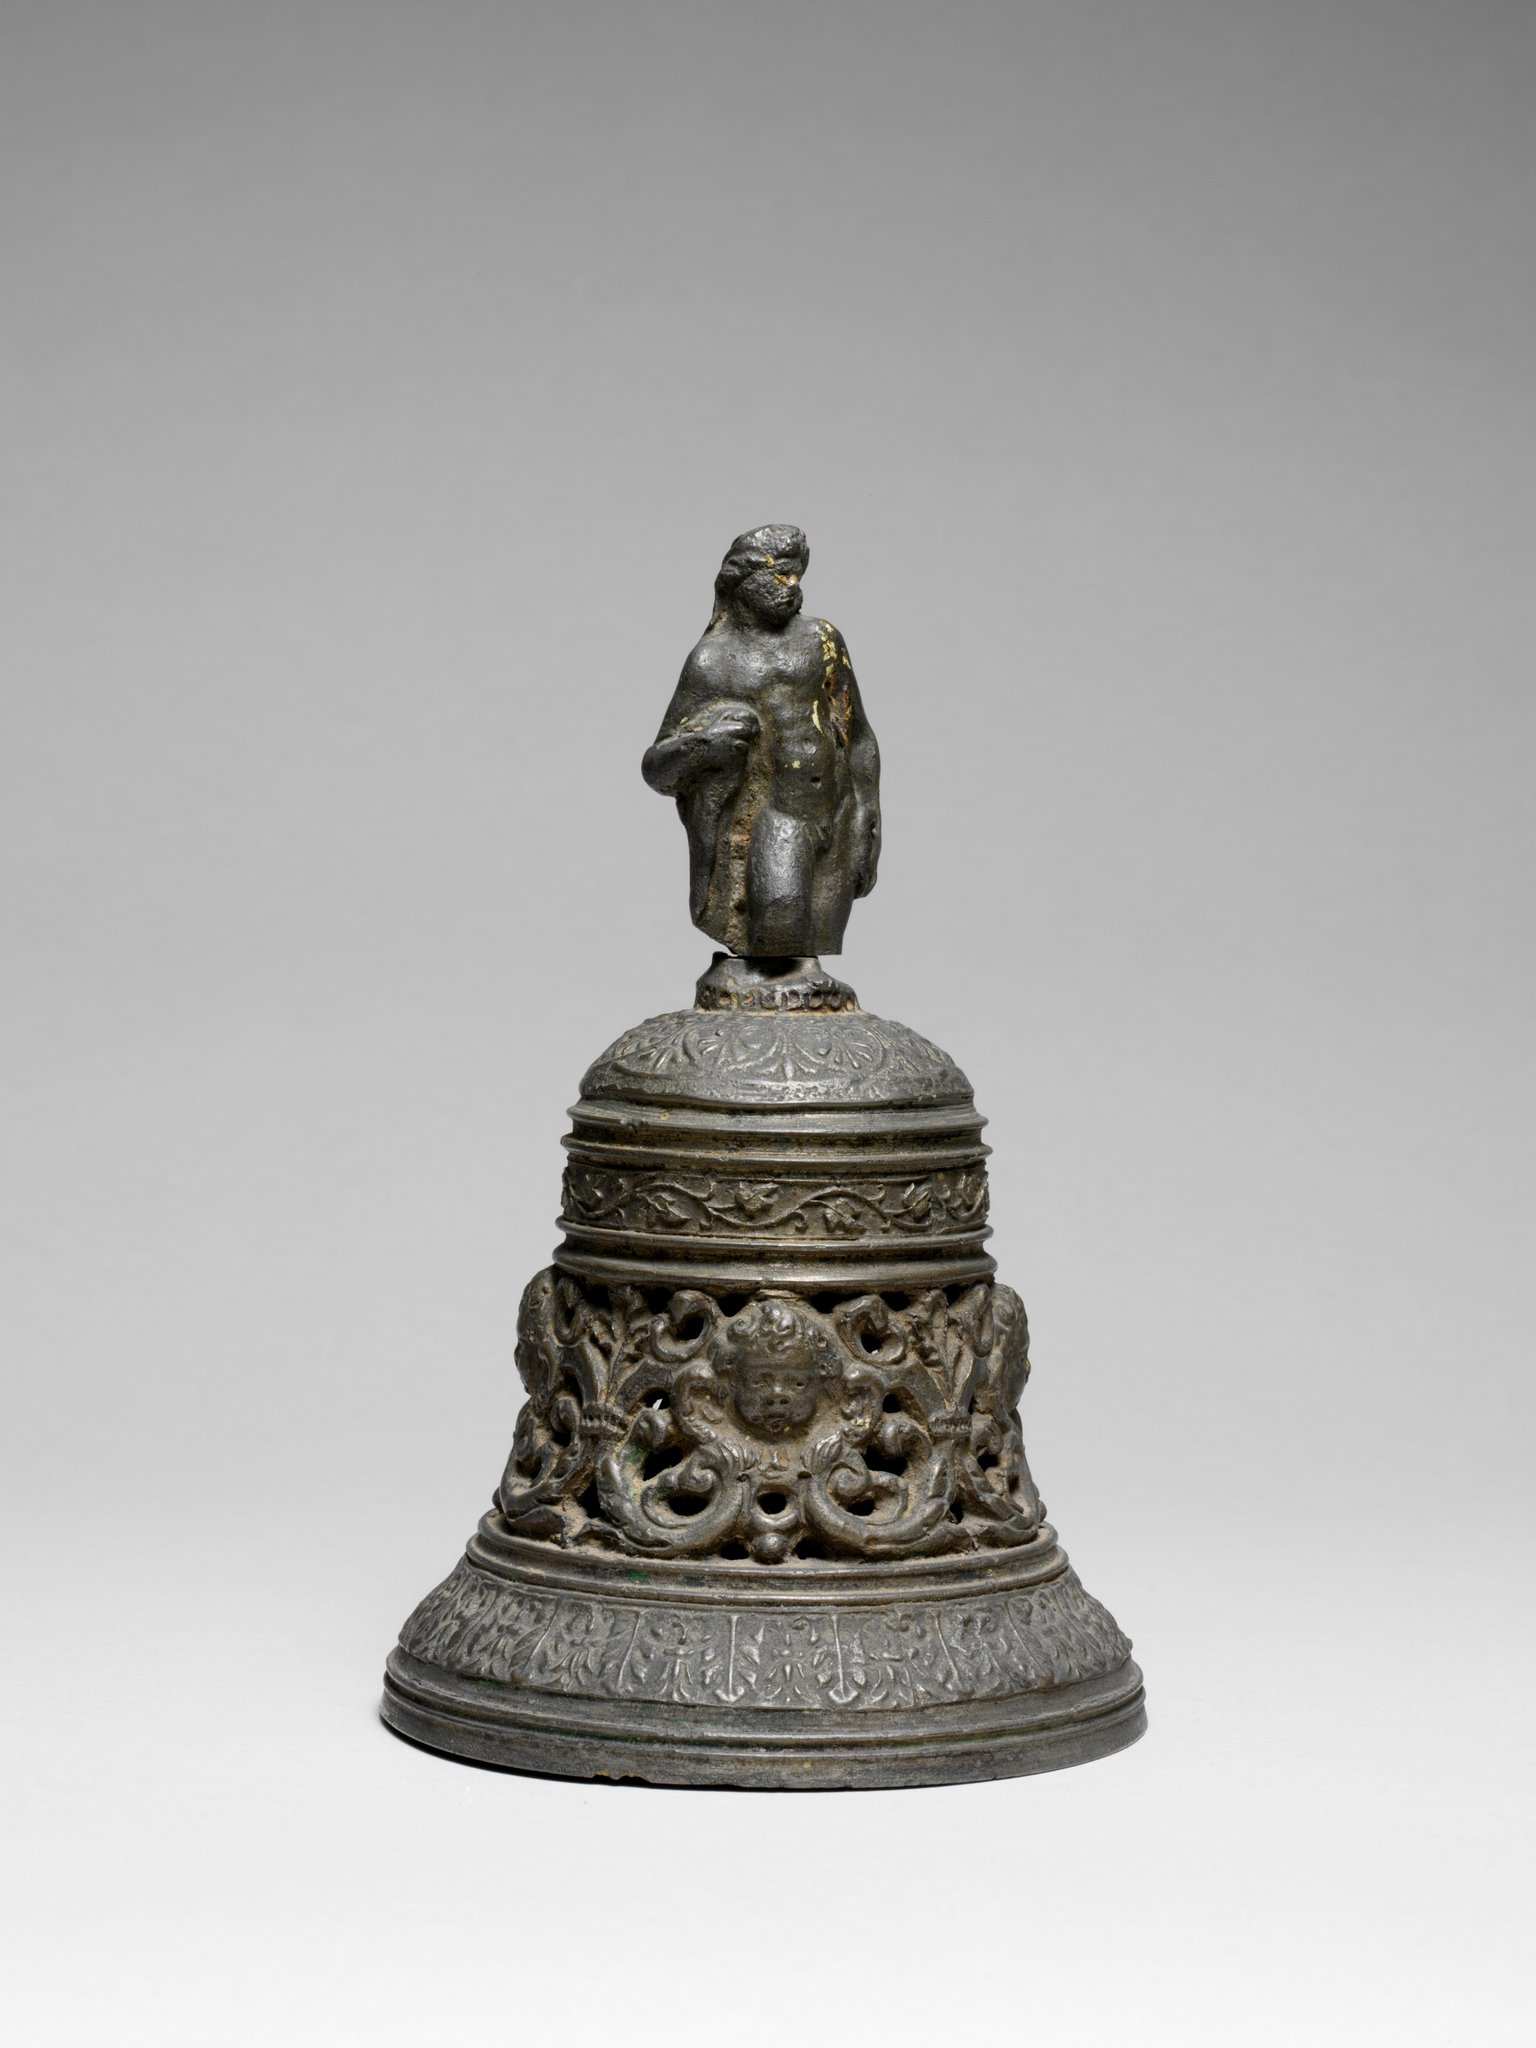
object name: handbell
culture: italian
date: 1801-1900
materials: metal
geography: italy